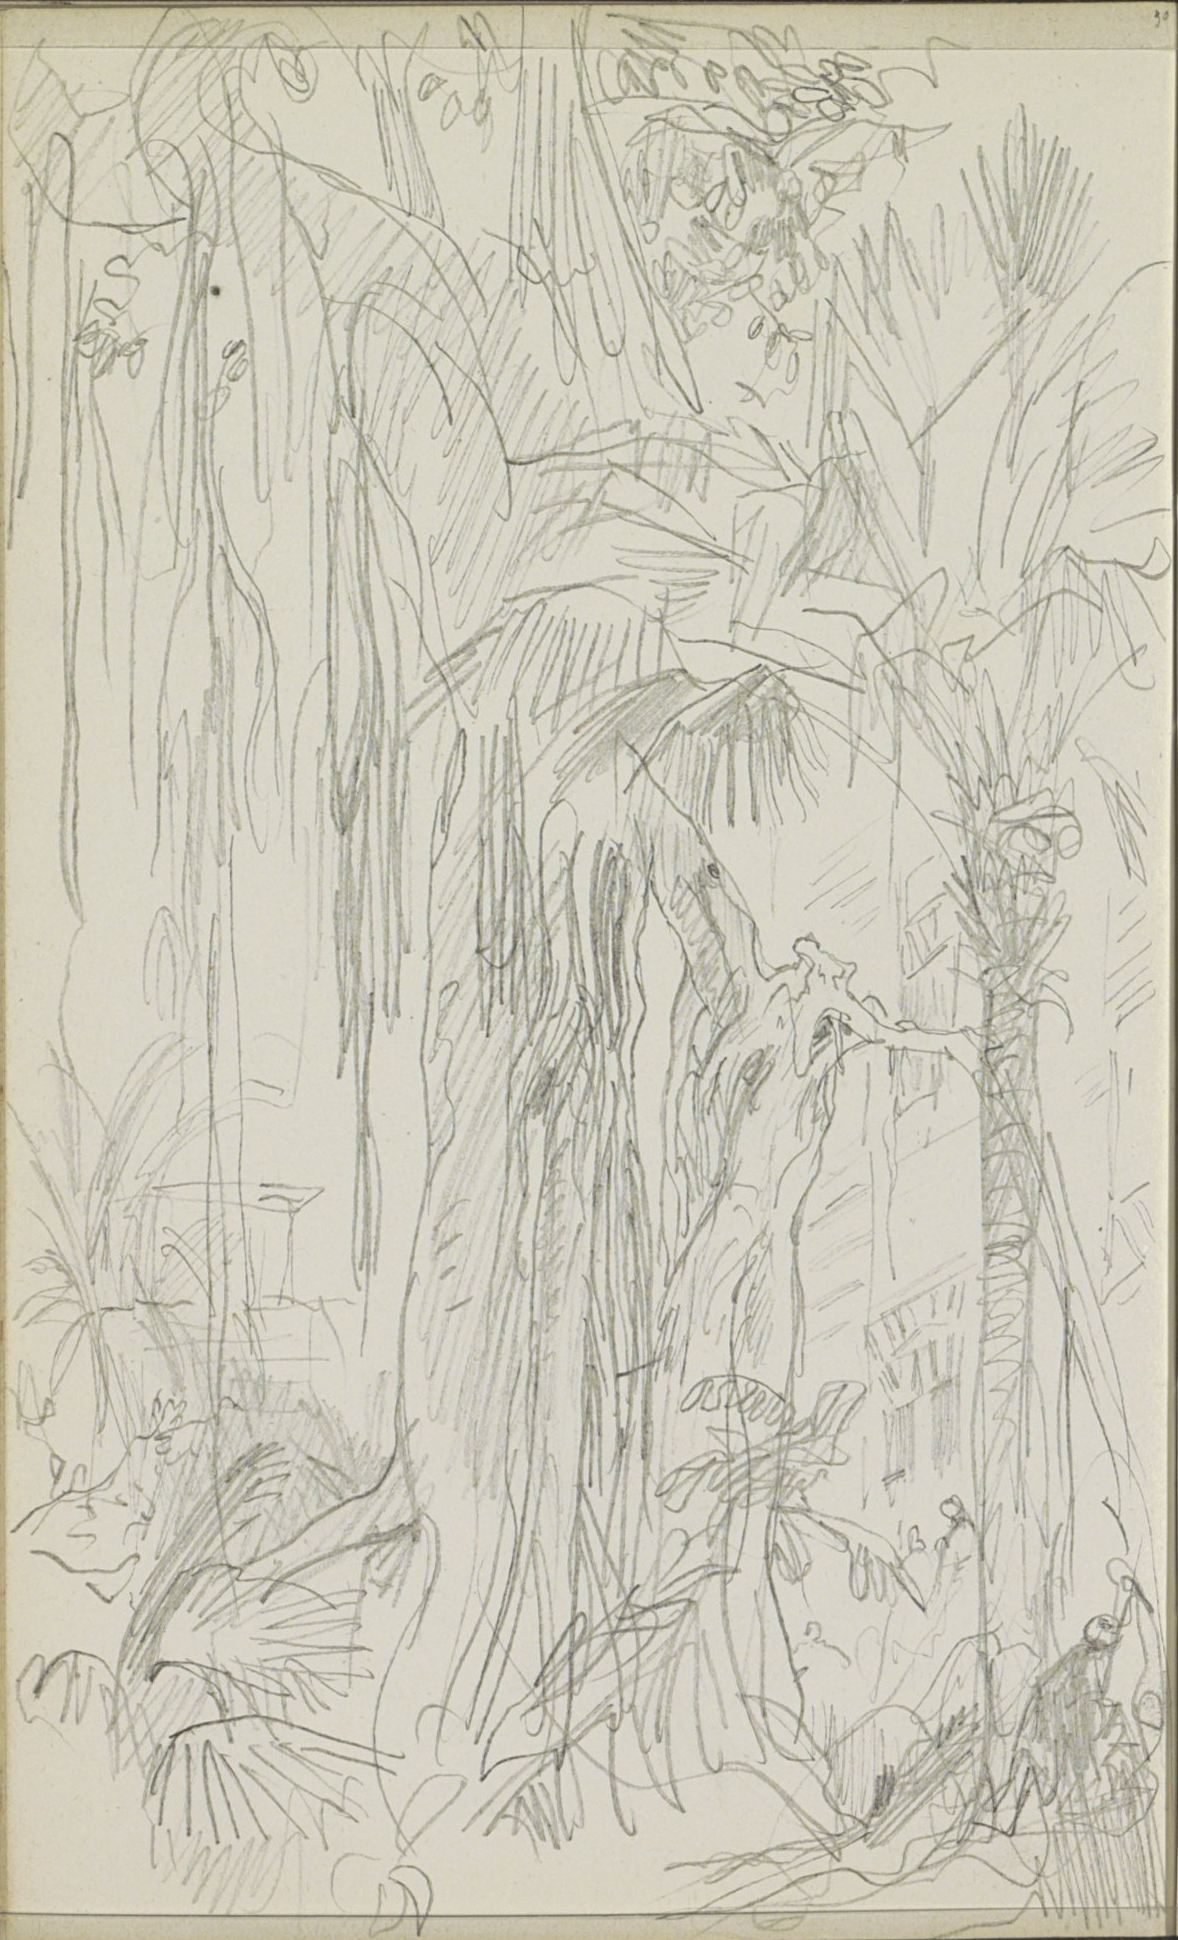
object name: sketchbook leaf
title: Figuren in een tuin met palmbomen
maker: marius bauer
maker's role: draughtsman, print maker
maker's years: 1867-1932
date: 1904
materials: paper, pencil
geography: cairo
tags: standing figure, garden, trees: palm-tree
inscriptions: kleurnotitie, handgeschreven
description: Pagina 90 uit een schetsboek met 56 bladen.